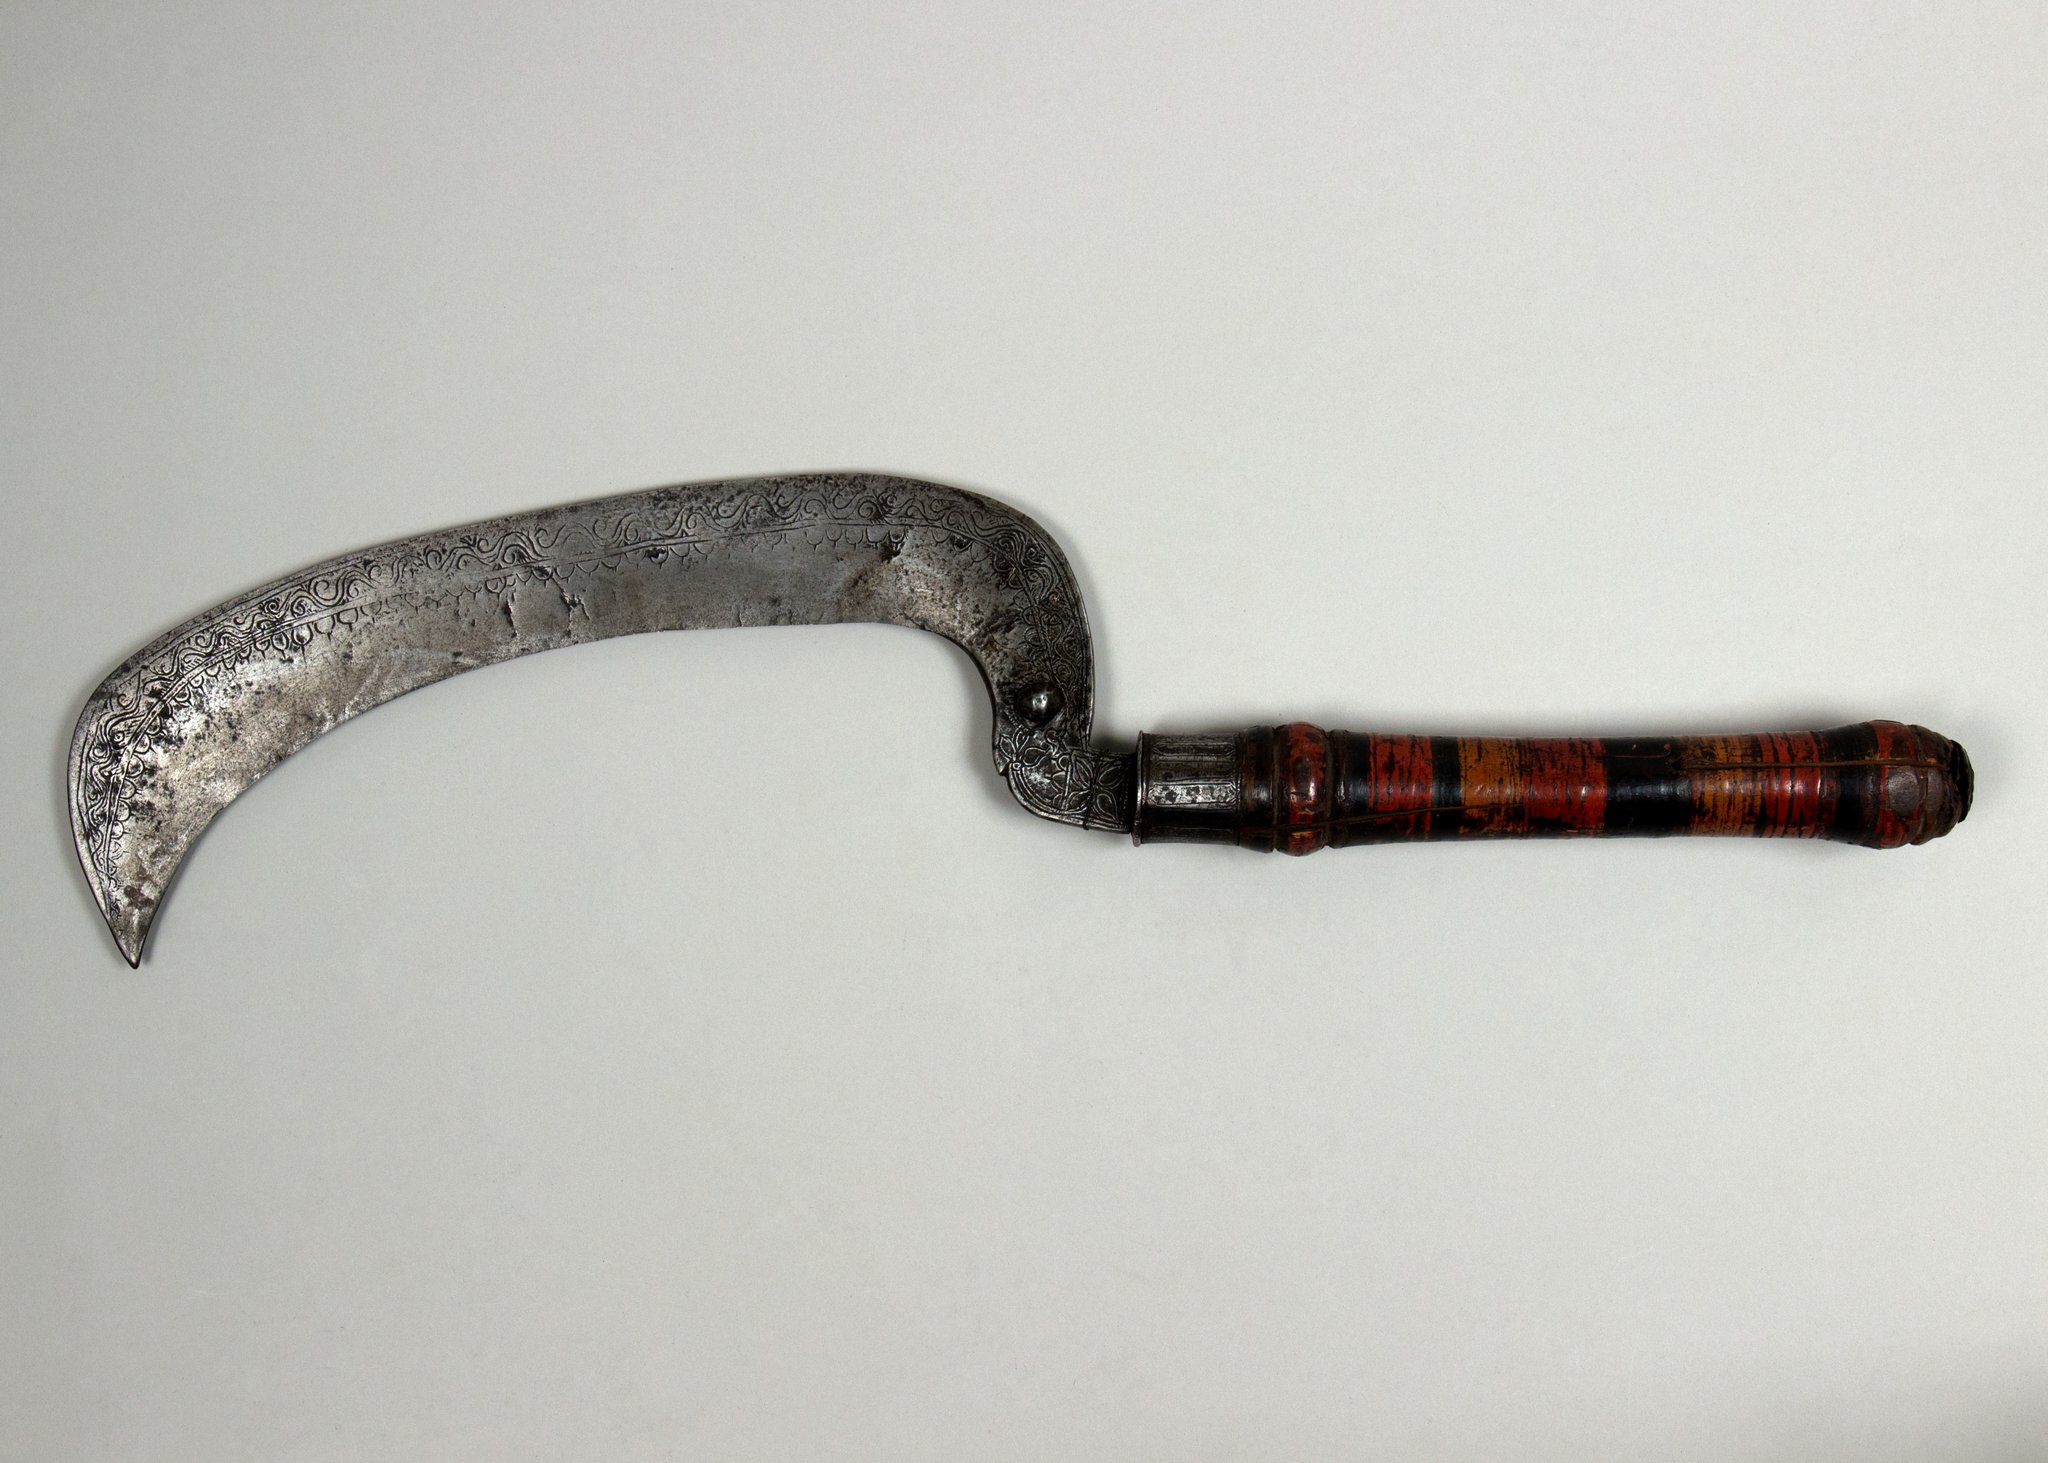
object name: sacrificial axe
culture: indian, coorg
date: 1701-1900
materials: steel, wood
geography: india